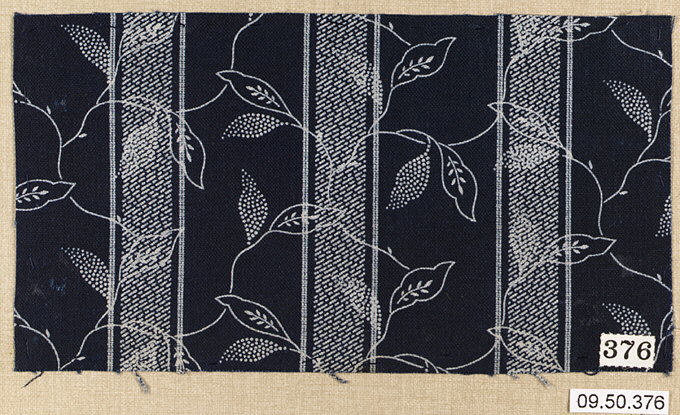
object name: piece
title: Piece (one of 116)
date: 1801-1900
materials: cotton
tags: leaves